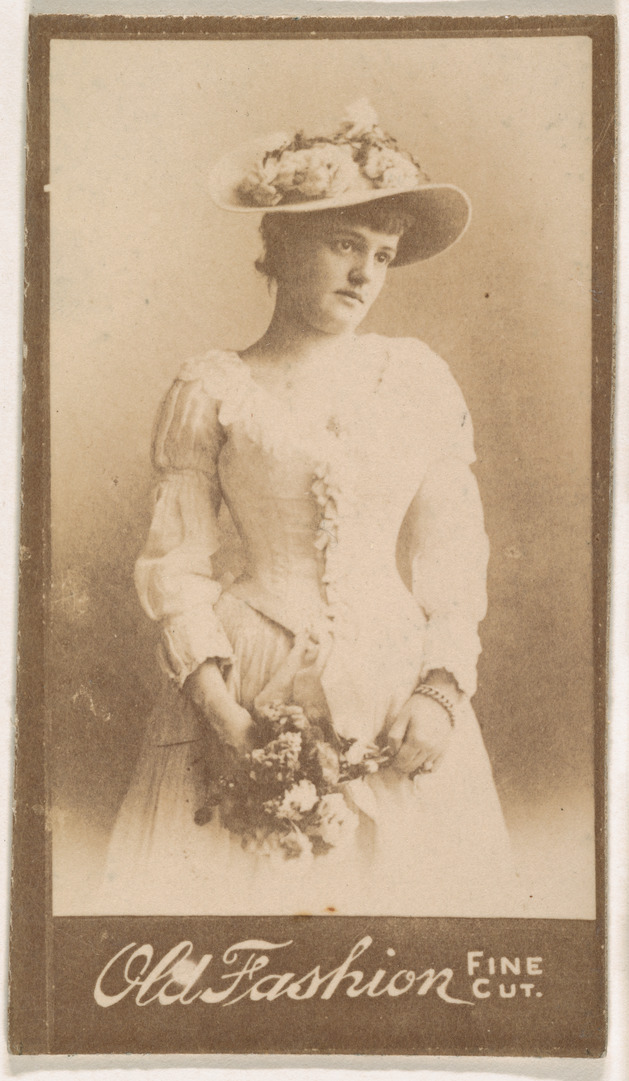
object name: photograph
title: Actress holding floral bouquet, from the Actresses series (N664) promoting Old Fashion Fine Cut Tobacco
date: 1888-1890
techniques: albumen silver print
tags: portraits,women,actresses